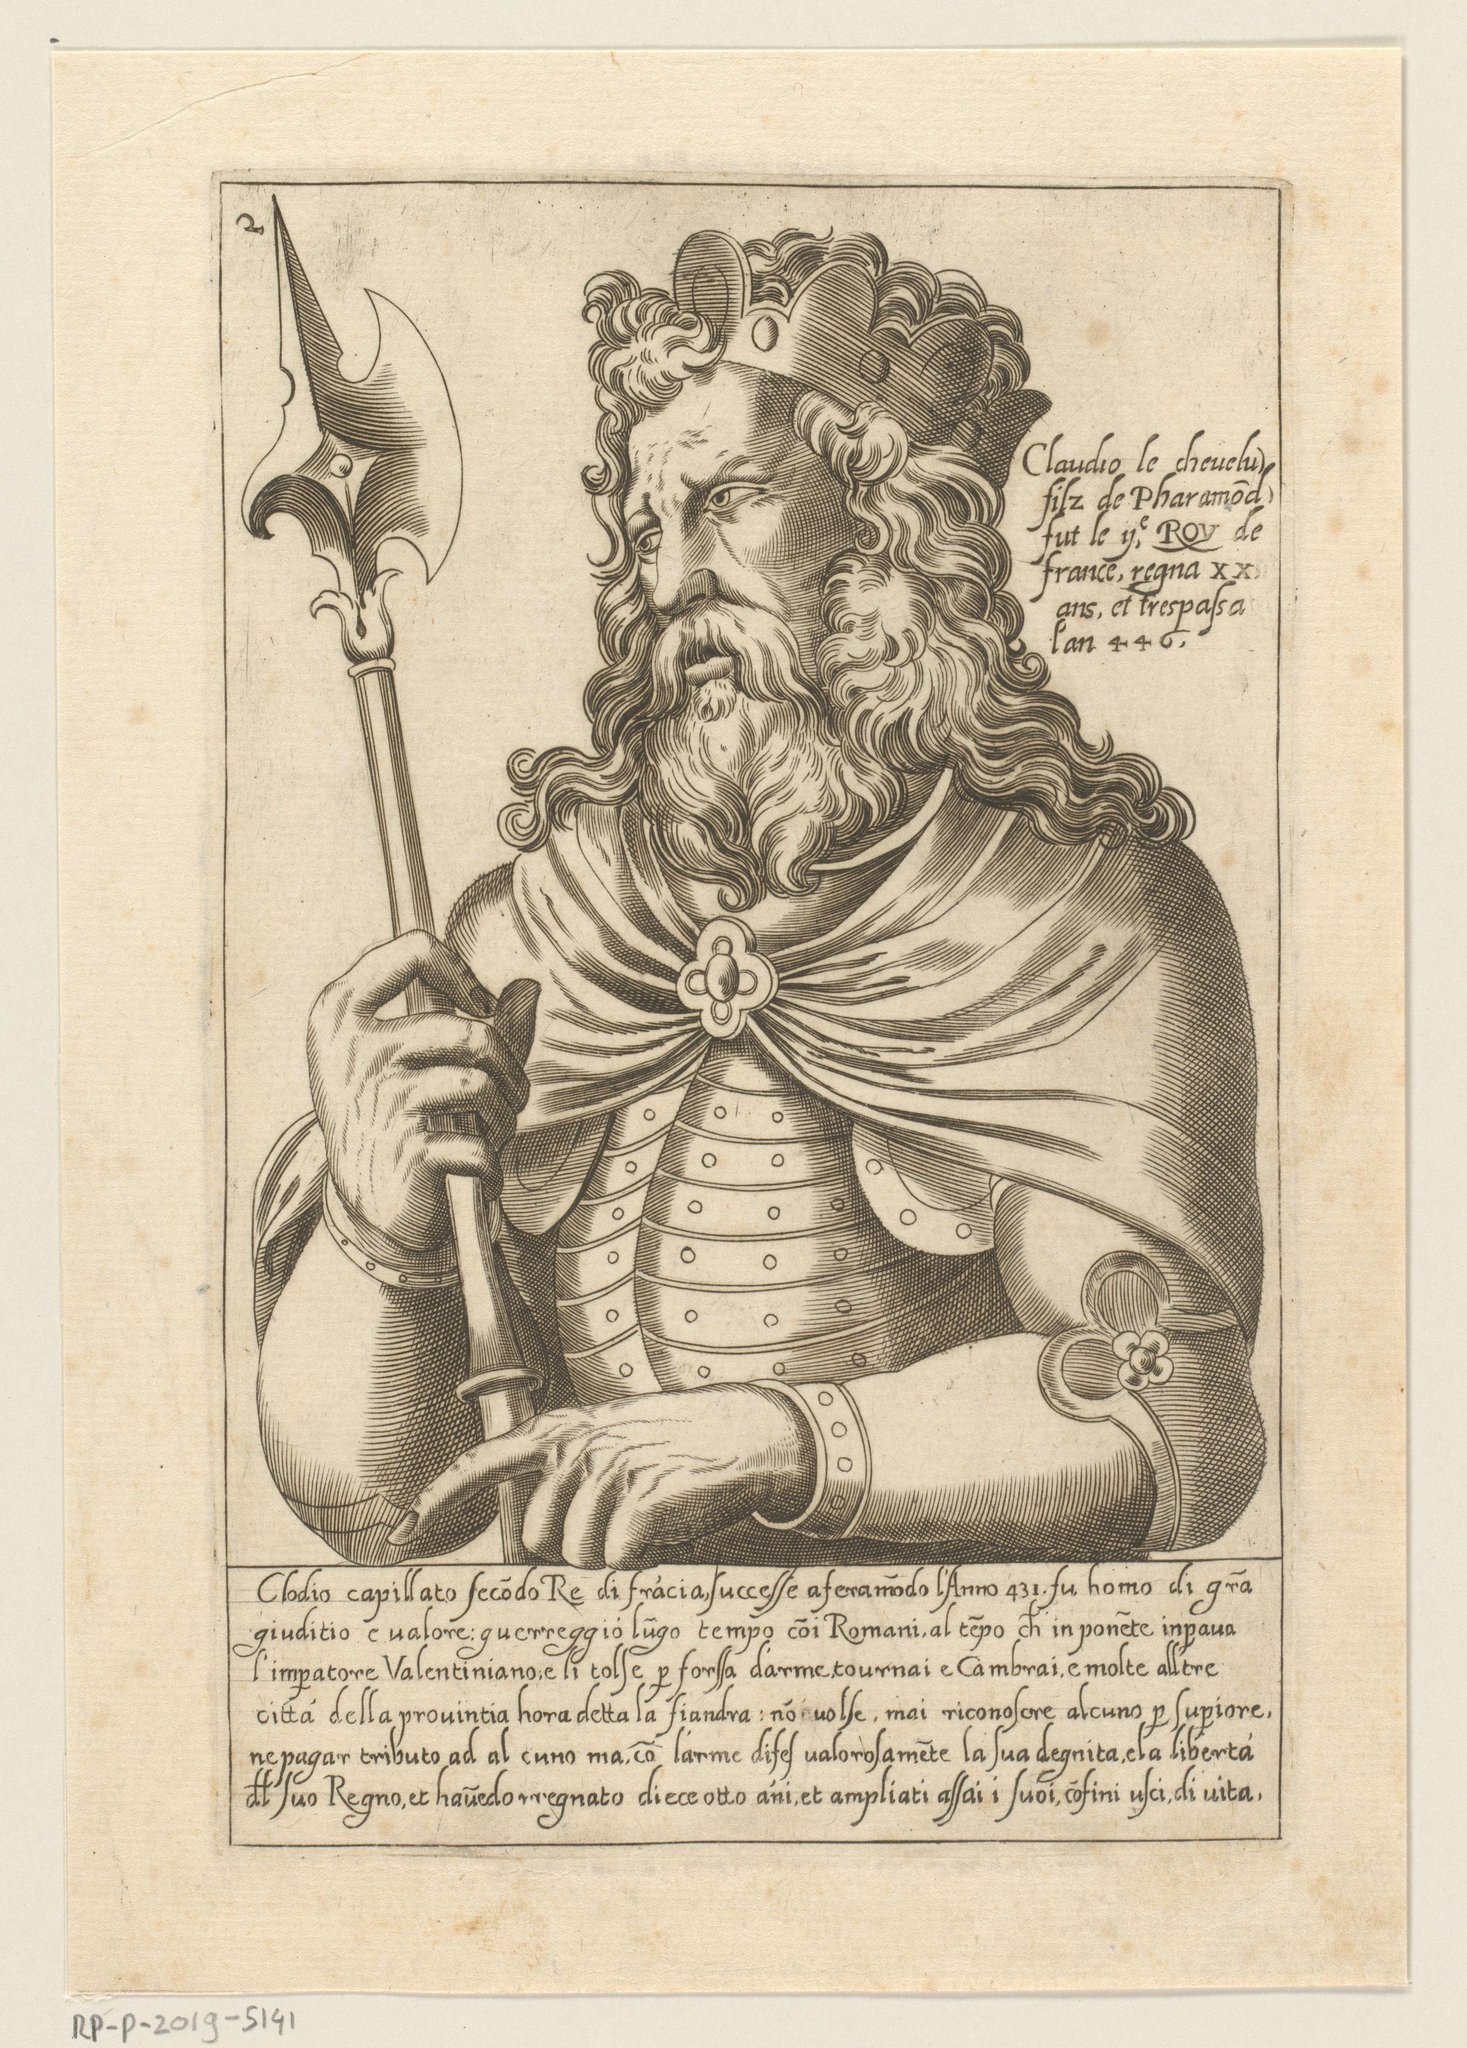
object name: print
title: Portret van Chlodio, koning der Franken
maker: Anonymous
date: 1588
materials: paper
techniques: engraving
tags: crown (symbol of sovereignty), historical persons, king, helved weapons, polearms (for striking, hacking, thrusting): halberd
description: Prent voor het eerst gebruikt in: Cronica Breve de i fatti illustri de're di Francia, con le loro effigie dal naturale cominciando da Faramondo (...). Venetië: Bernardo Giunti, 1588. Prent in ieder geval ook gebruikt in de editie van 1590 en mogelijk ook in een Franse uitgave van 1597.